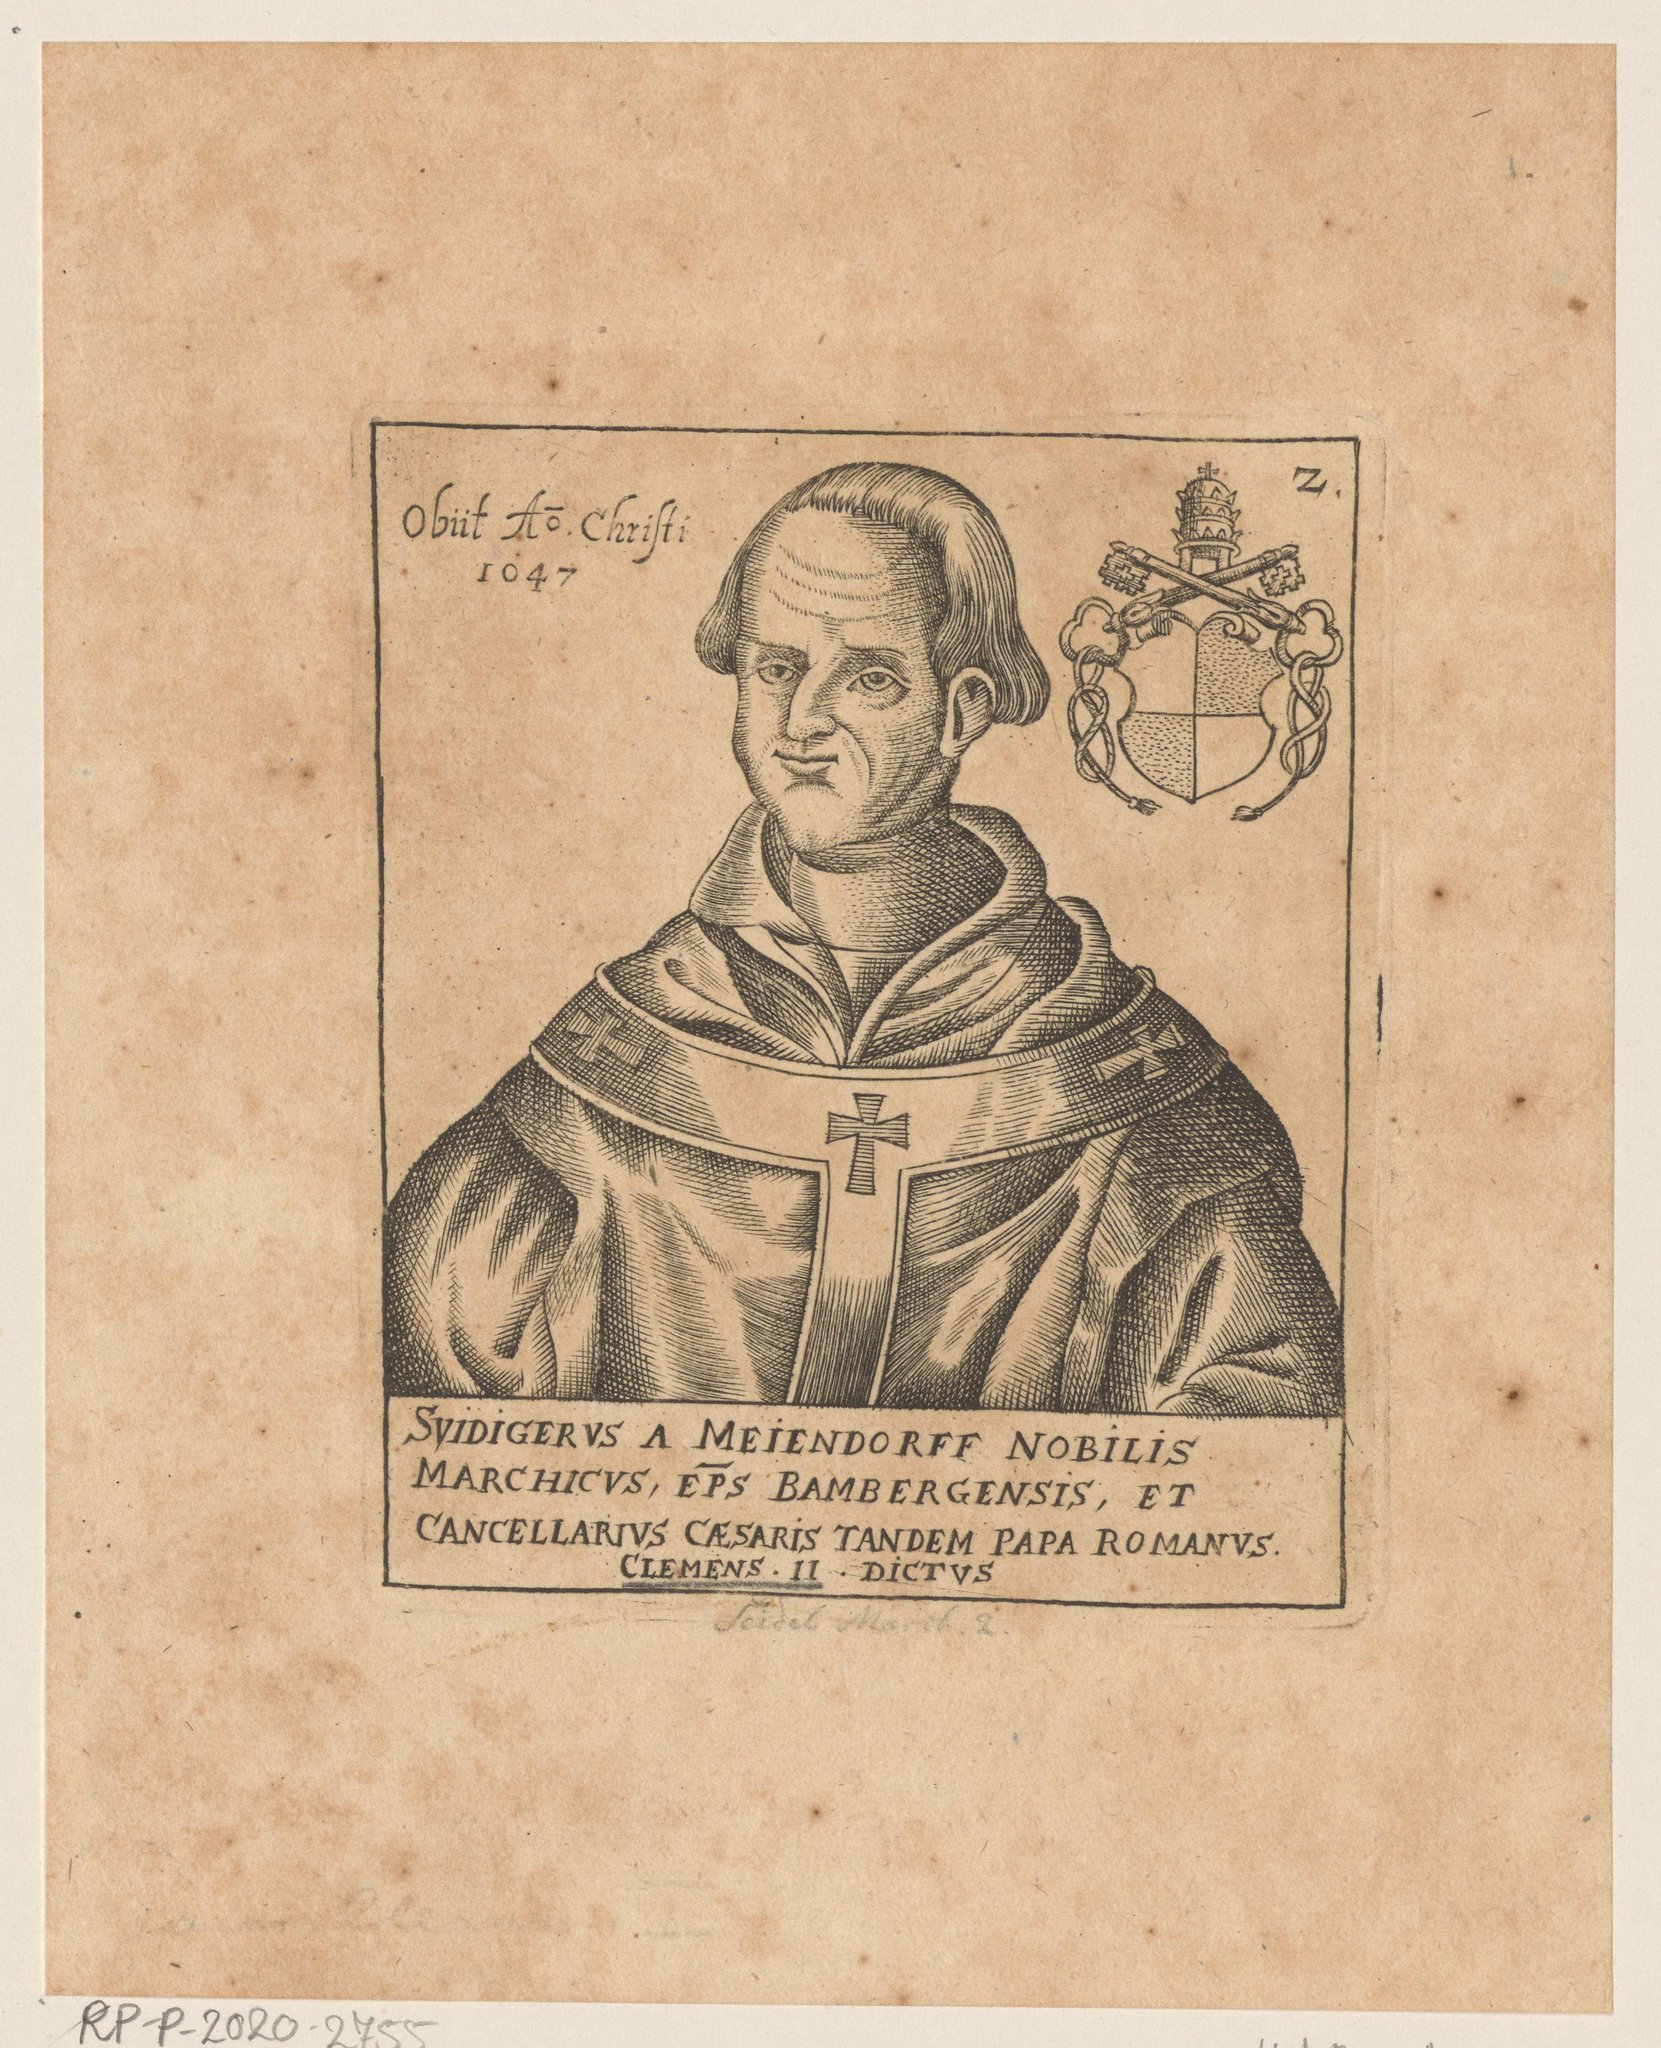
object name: print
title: Portret van paus Clemens II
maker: Anonymous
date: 1671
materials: paper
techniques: engraving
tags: historical persons, pope, armorial bearing, heraldry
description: Prent mogelijk uit: Seidel, Martin Friedrich. Icones et elogia virorum aliquot praestantium qui multum studiis suis consiliisq (...). S.l.s.n., 1671.